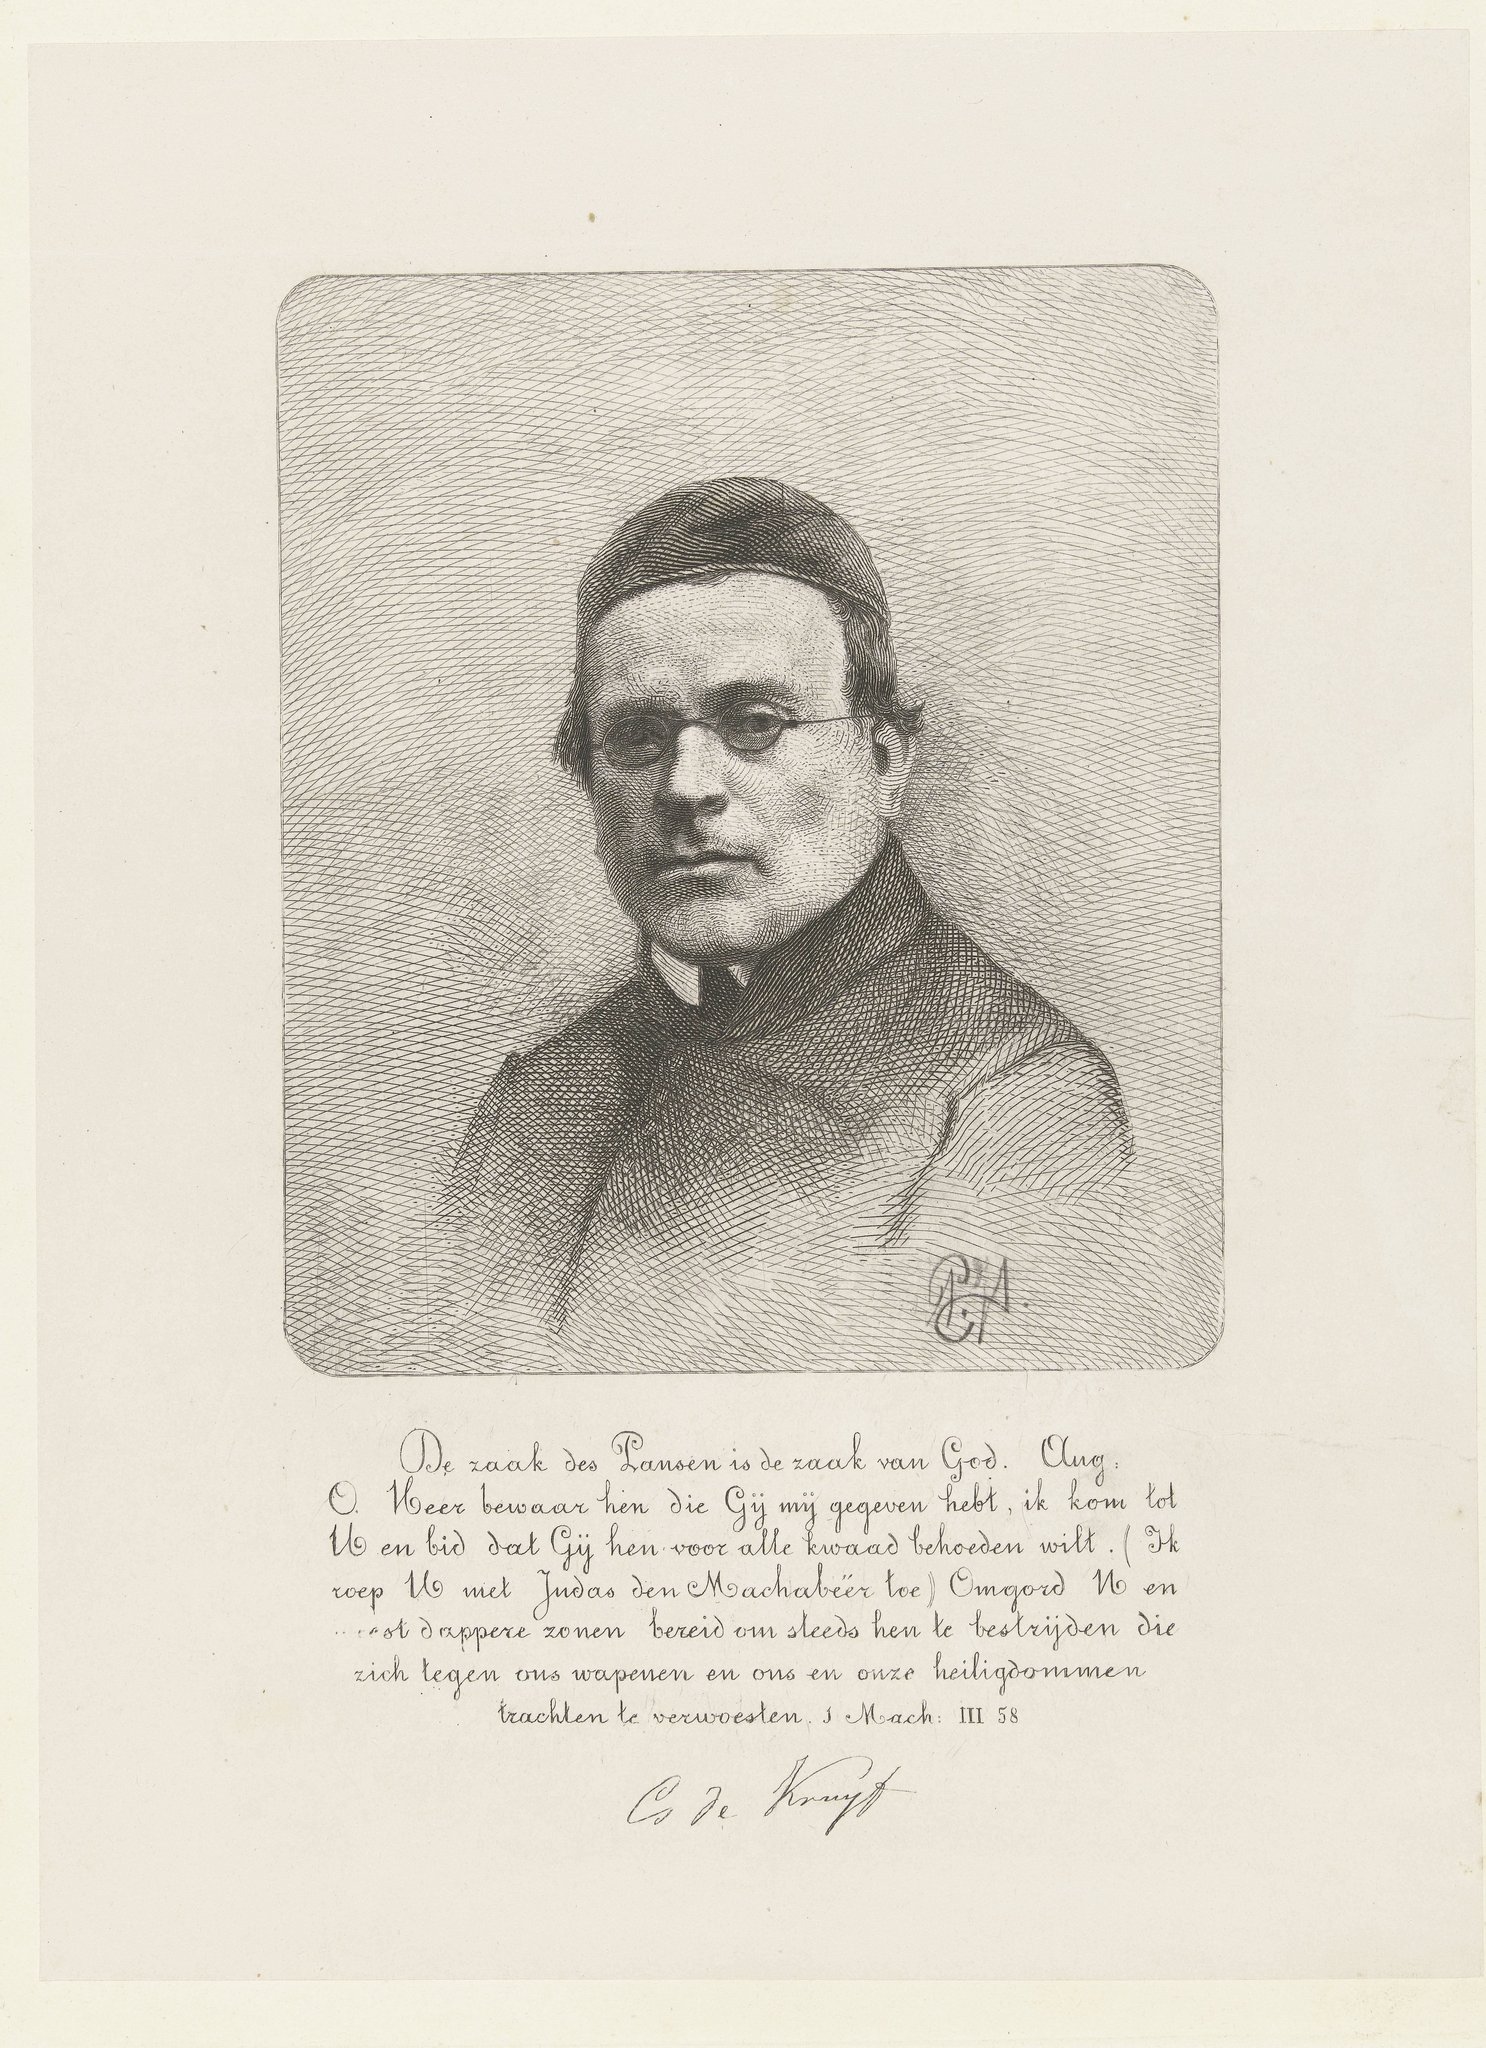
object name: print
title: Portret van C.B. de Kruyf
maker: petrus johannes arendzen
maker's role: draughtsman, print maker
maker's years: 1846-1932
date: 1856-1874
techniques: printmaking, engraving, etching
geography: netherlands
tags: amsterdam, priest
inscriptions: collector's mark: Lugt 2228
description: Borstbeeld van C.B. de Kruyf, katholiek priester te Amsterdam. Onder het portret een bijbelvers van 7 regels uit 1 Mach. 3, 58 en een facsimile van zijn handtekening.